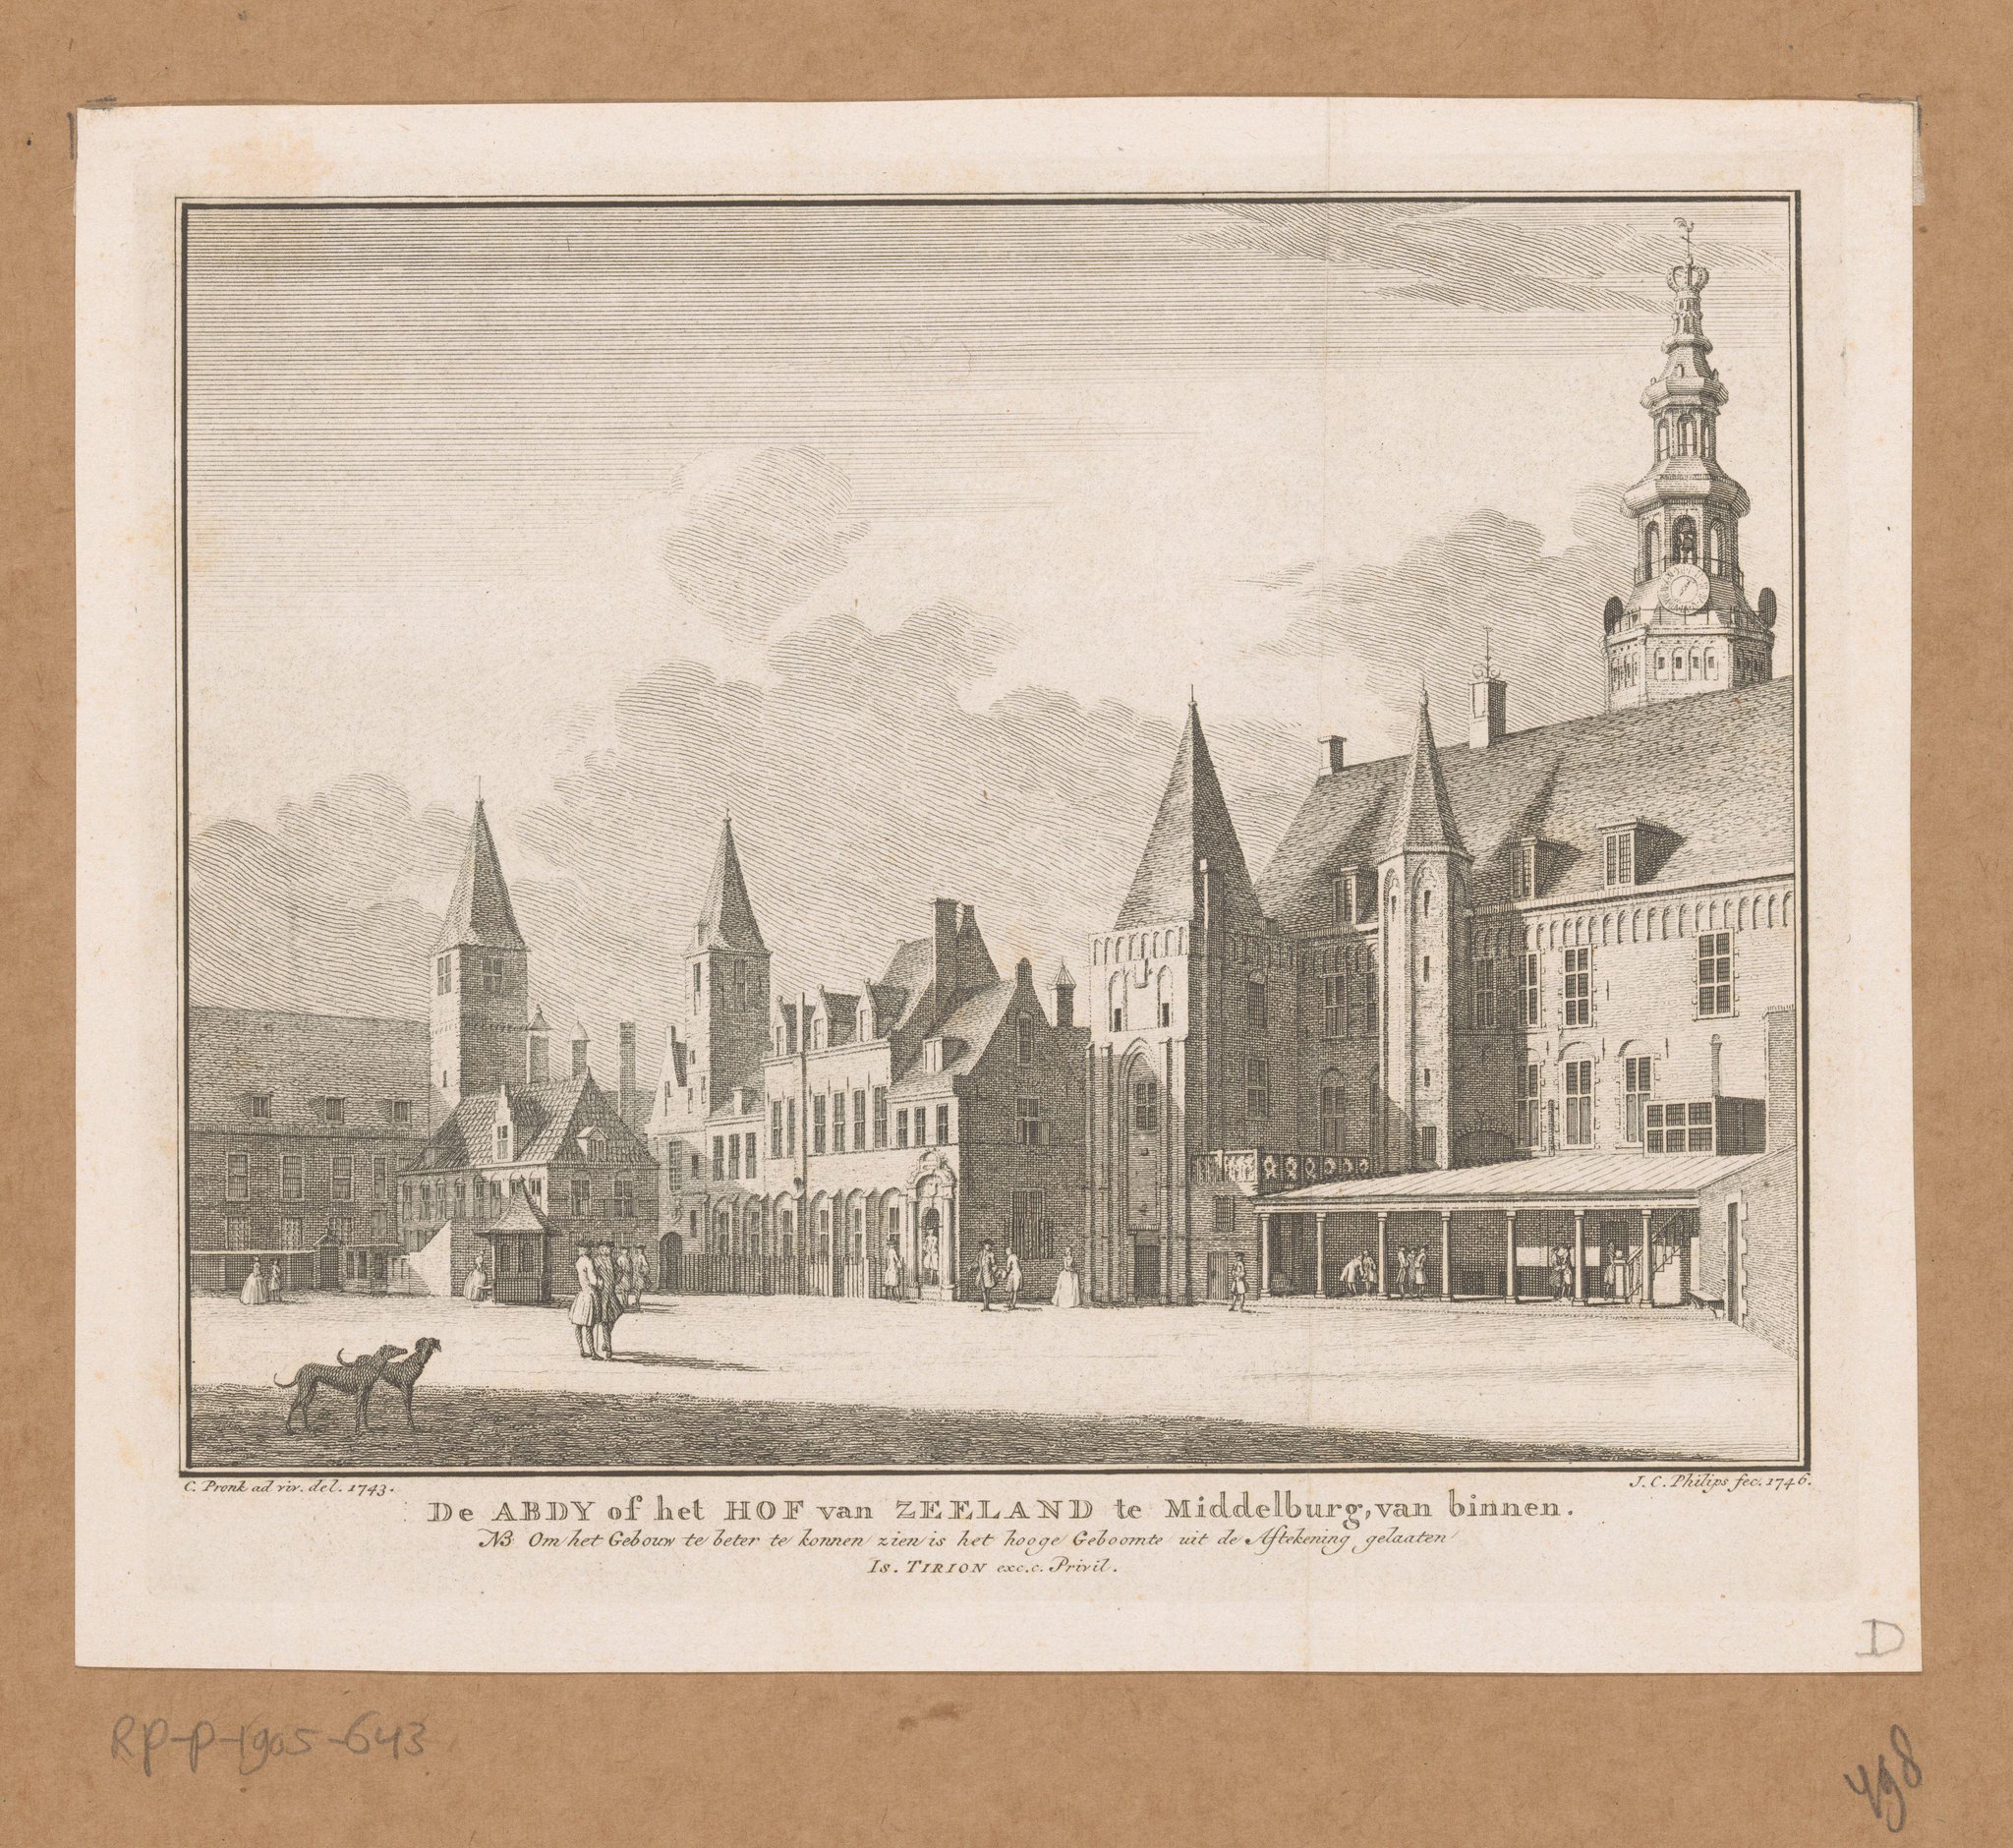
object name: book illustration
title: Gezicht op het Abdijplein te Middelburg, 1743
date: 1746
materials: paper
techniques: etching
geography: amsterdam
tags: abbey, monastery, convent ~ roman catholic church, law and jurisprudence (+ court building)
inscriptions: collector's mark: Lugt 2228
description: Gezicht op het Abdijplein te Middelburg, in de situatie omstreeks 1743. Het Hof van Zeeland zetelde in de gebouwen van de voormalige abdij aan het Abdijplein. Rechts op de achtergrond de Lange Jan.